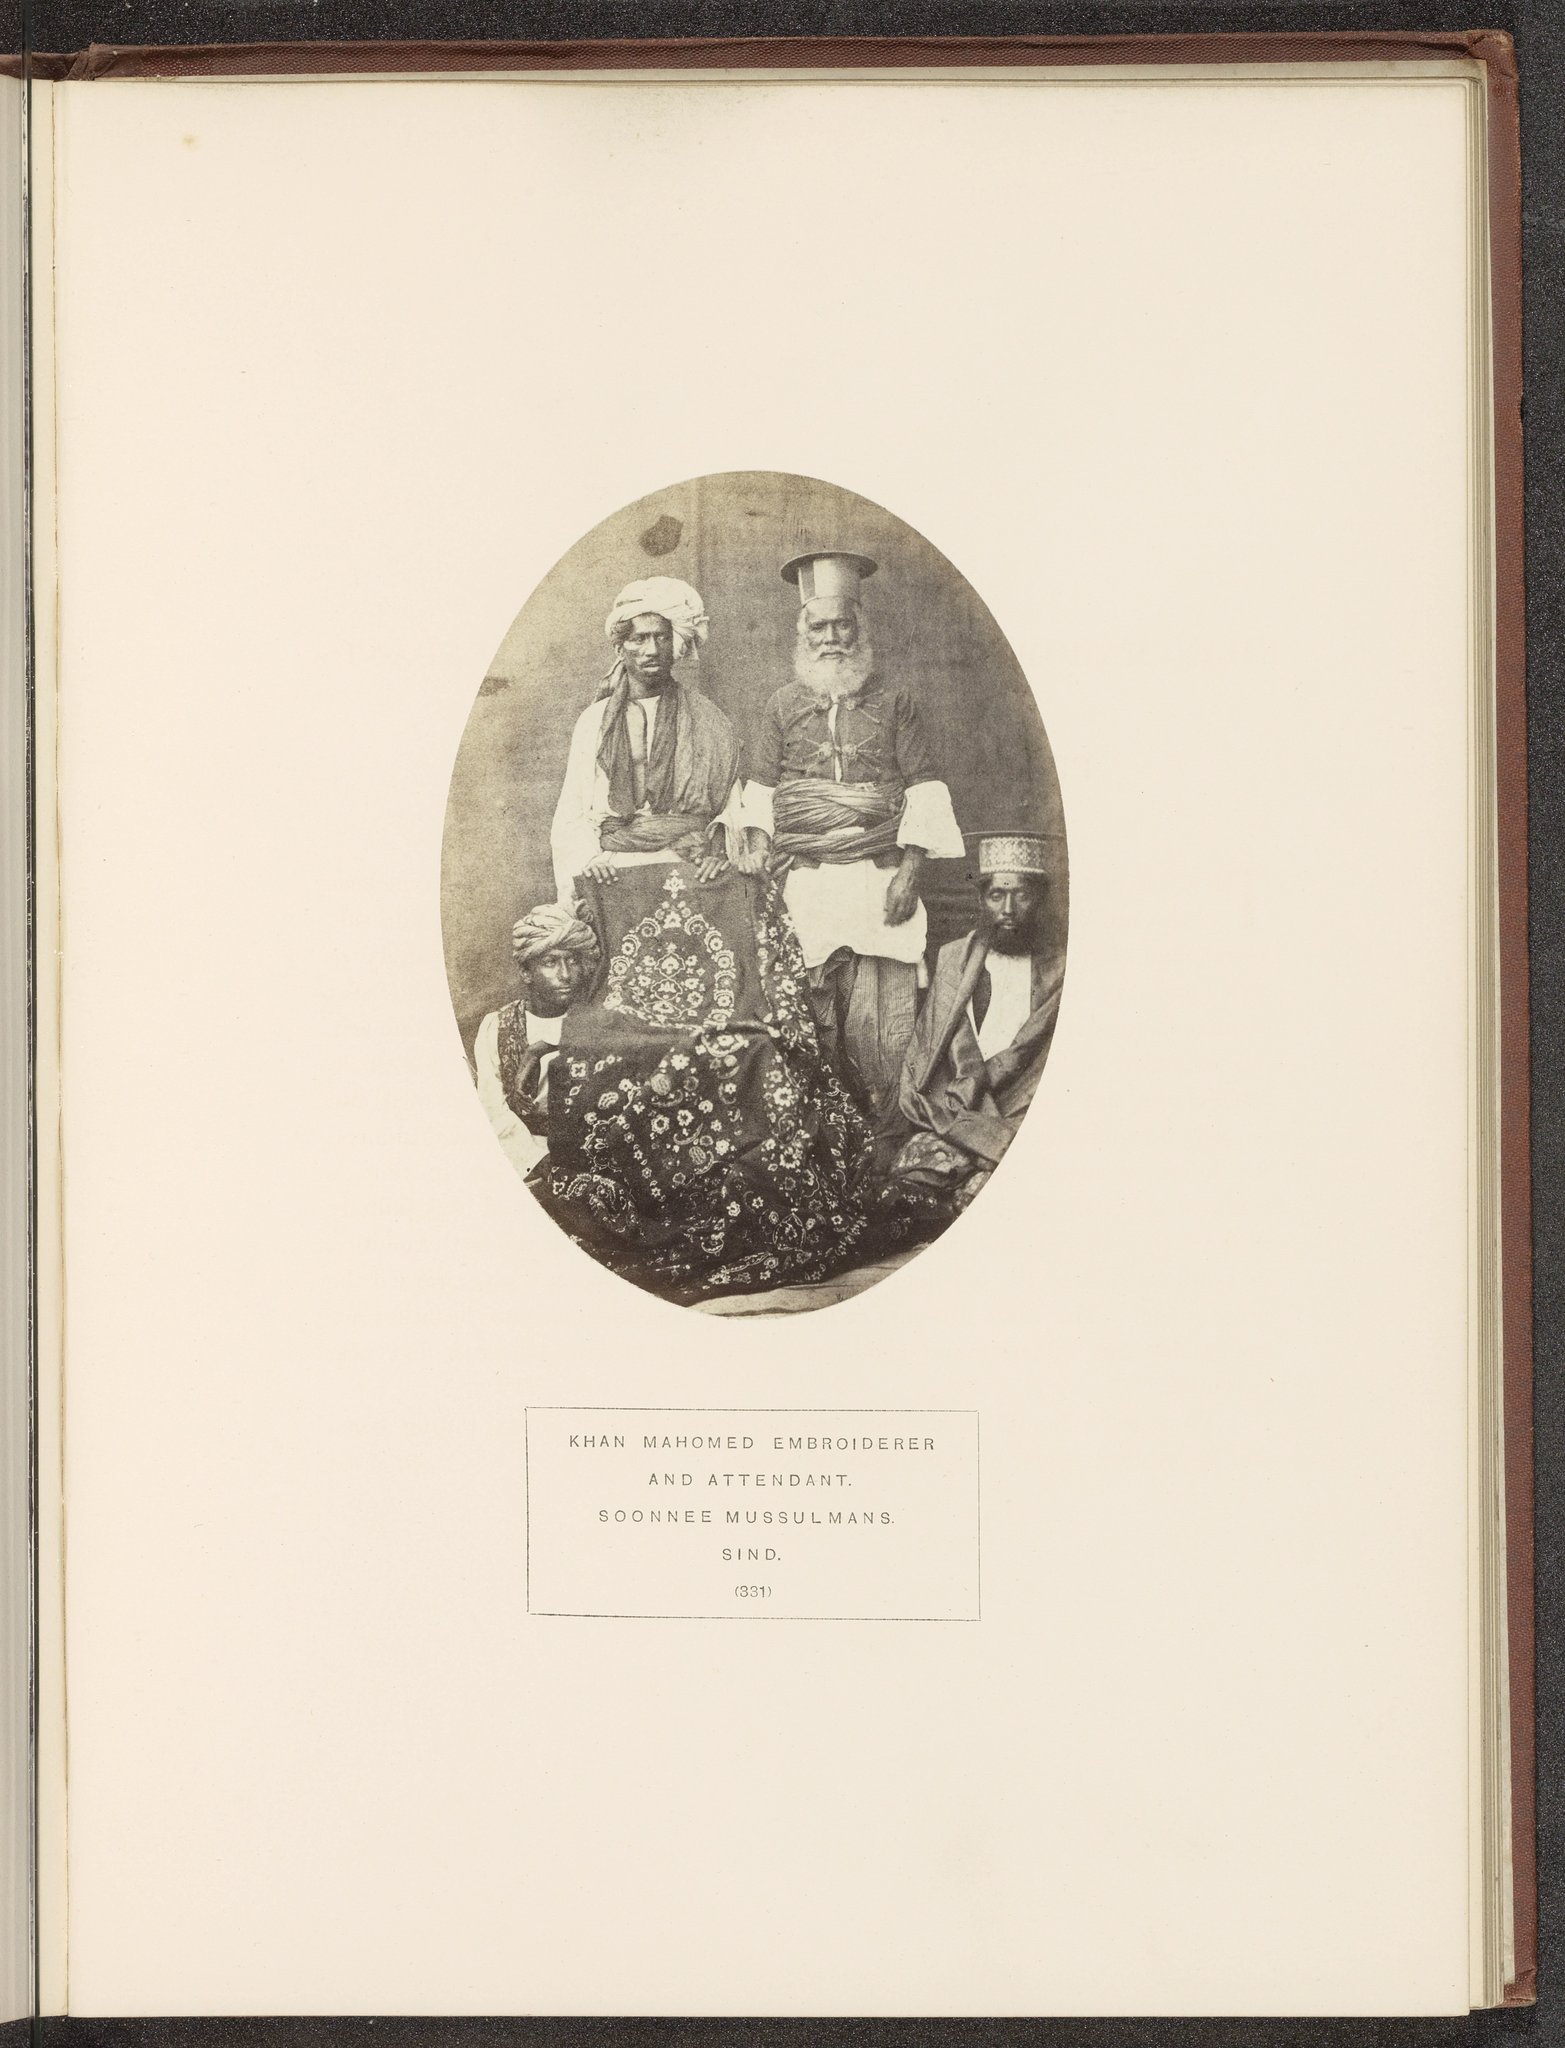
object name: page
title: Portrait of Khan Mahomed, an embroiderer with three attendants in Sindh, Pakistan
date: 1862-1872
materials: photographic support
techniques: albumen print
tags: embroidering ~ textile industry, head-gear: turban, human races; peoples; nationalities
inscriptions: inscription: ‘KHAN MAHOMED EMBROIDERER/ AND ATTENDANT./ SONNEE MUSSULMANS./ SIND.’, number: ‘(331)’